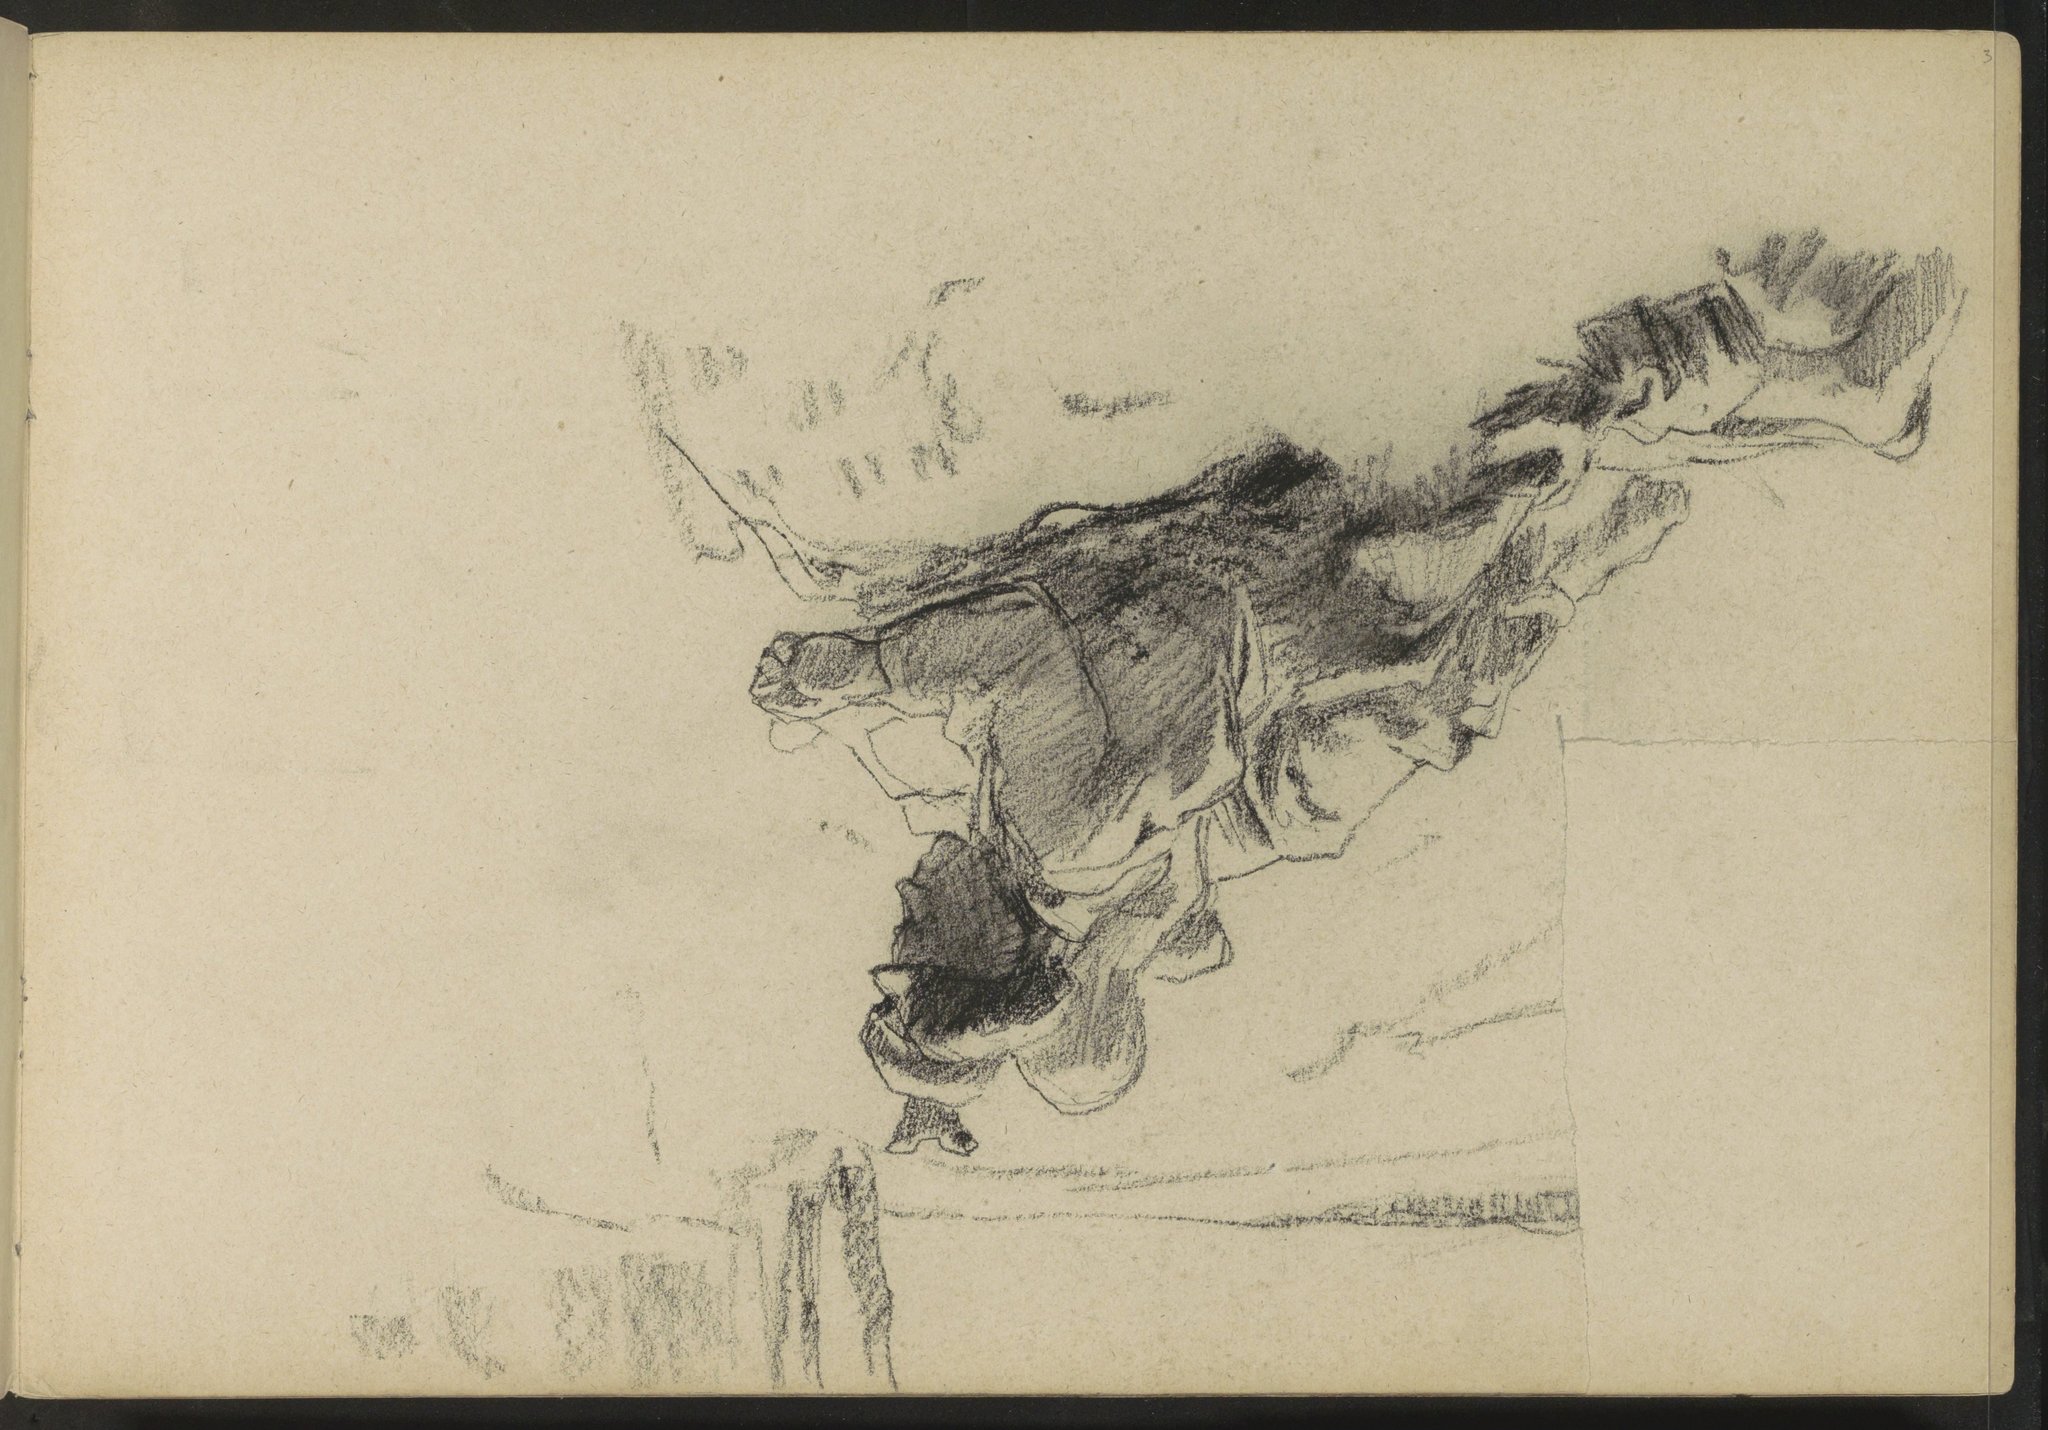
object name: sketchbook leaf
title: Landschap met twee liggende figuren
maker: willem witsen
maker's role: draughtsman, painter, print maker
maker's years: 1860-1923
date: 1884-1887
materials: chalk, paper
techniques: stumping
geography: ewijkshoeve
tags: herding, herdsman, herdswoman, shepherd, shepherdess, cowherd, etc., landscapes in the temperate zone, farmers, lying figure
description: Mogelijk een boer en/of een herder. In de verte een hond. Pagina 3 uit een schetsboek met 29 bladen.